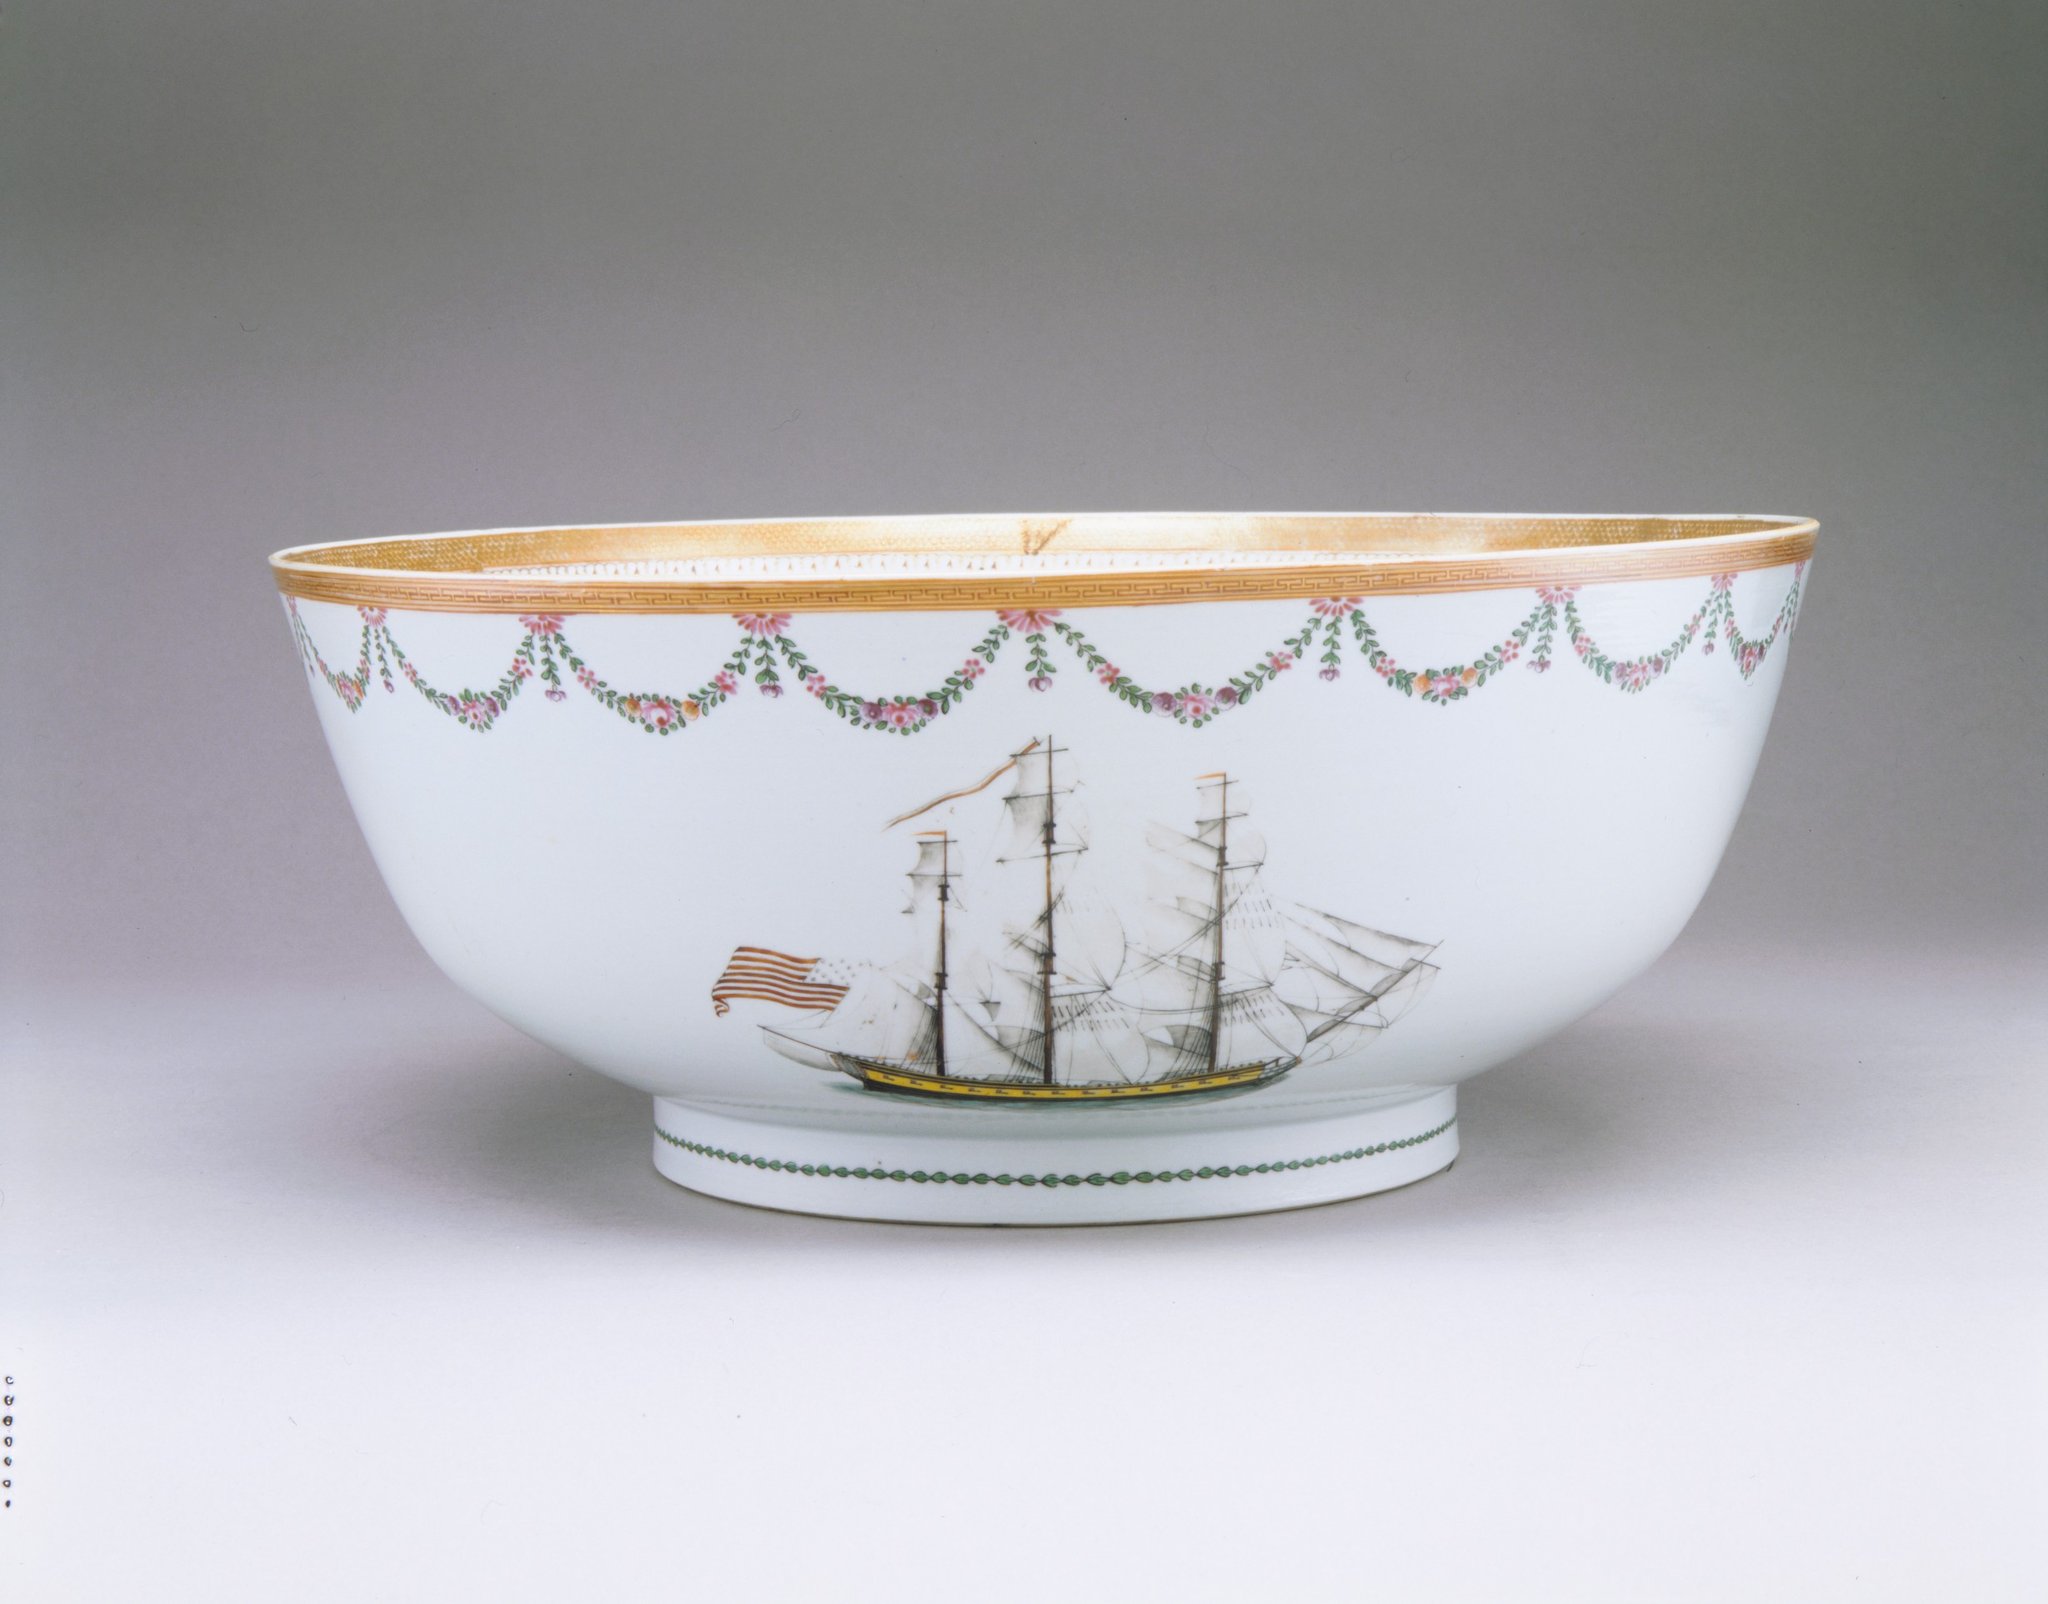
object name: punch bowl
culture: chinese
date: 1790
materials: porcelain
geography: china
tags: ships